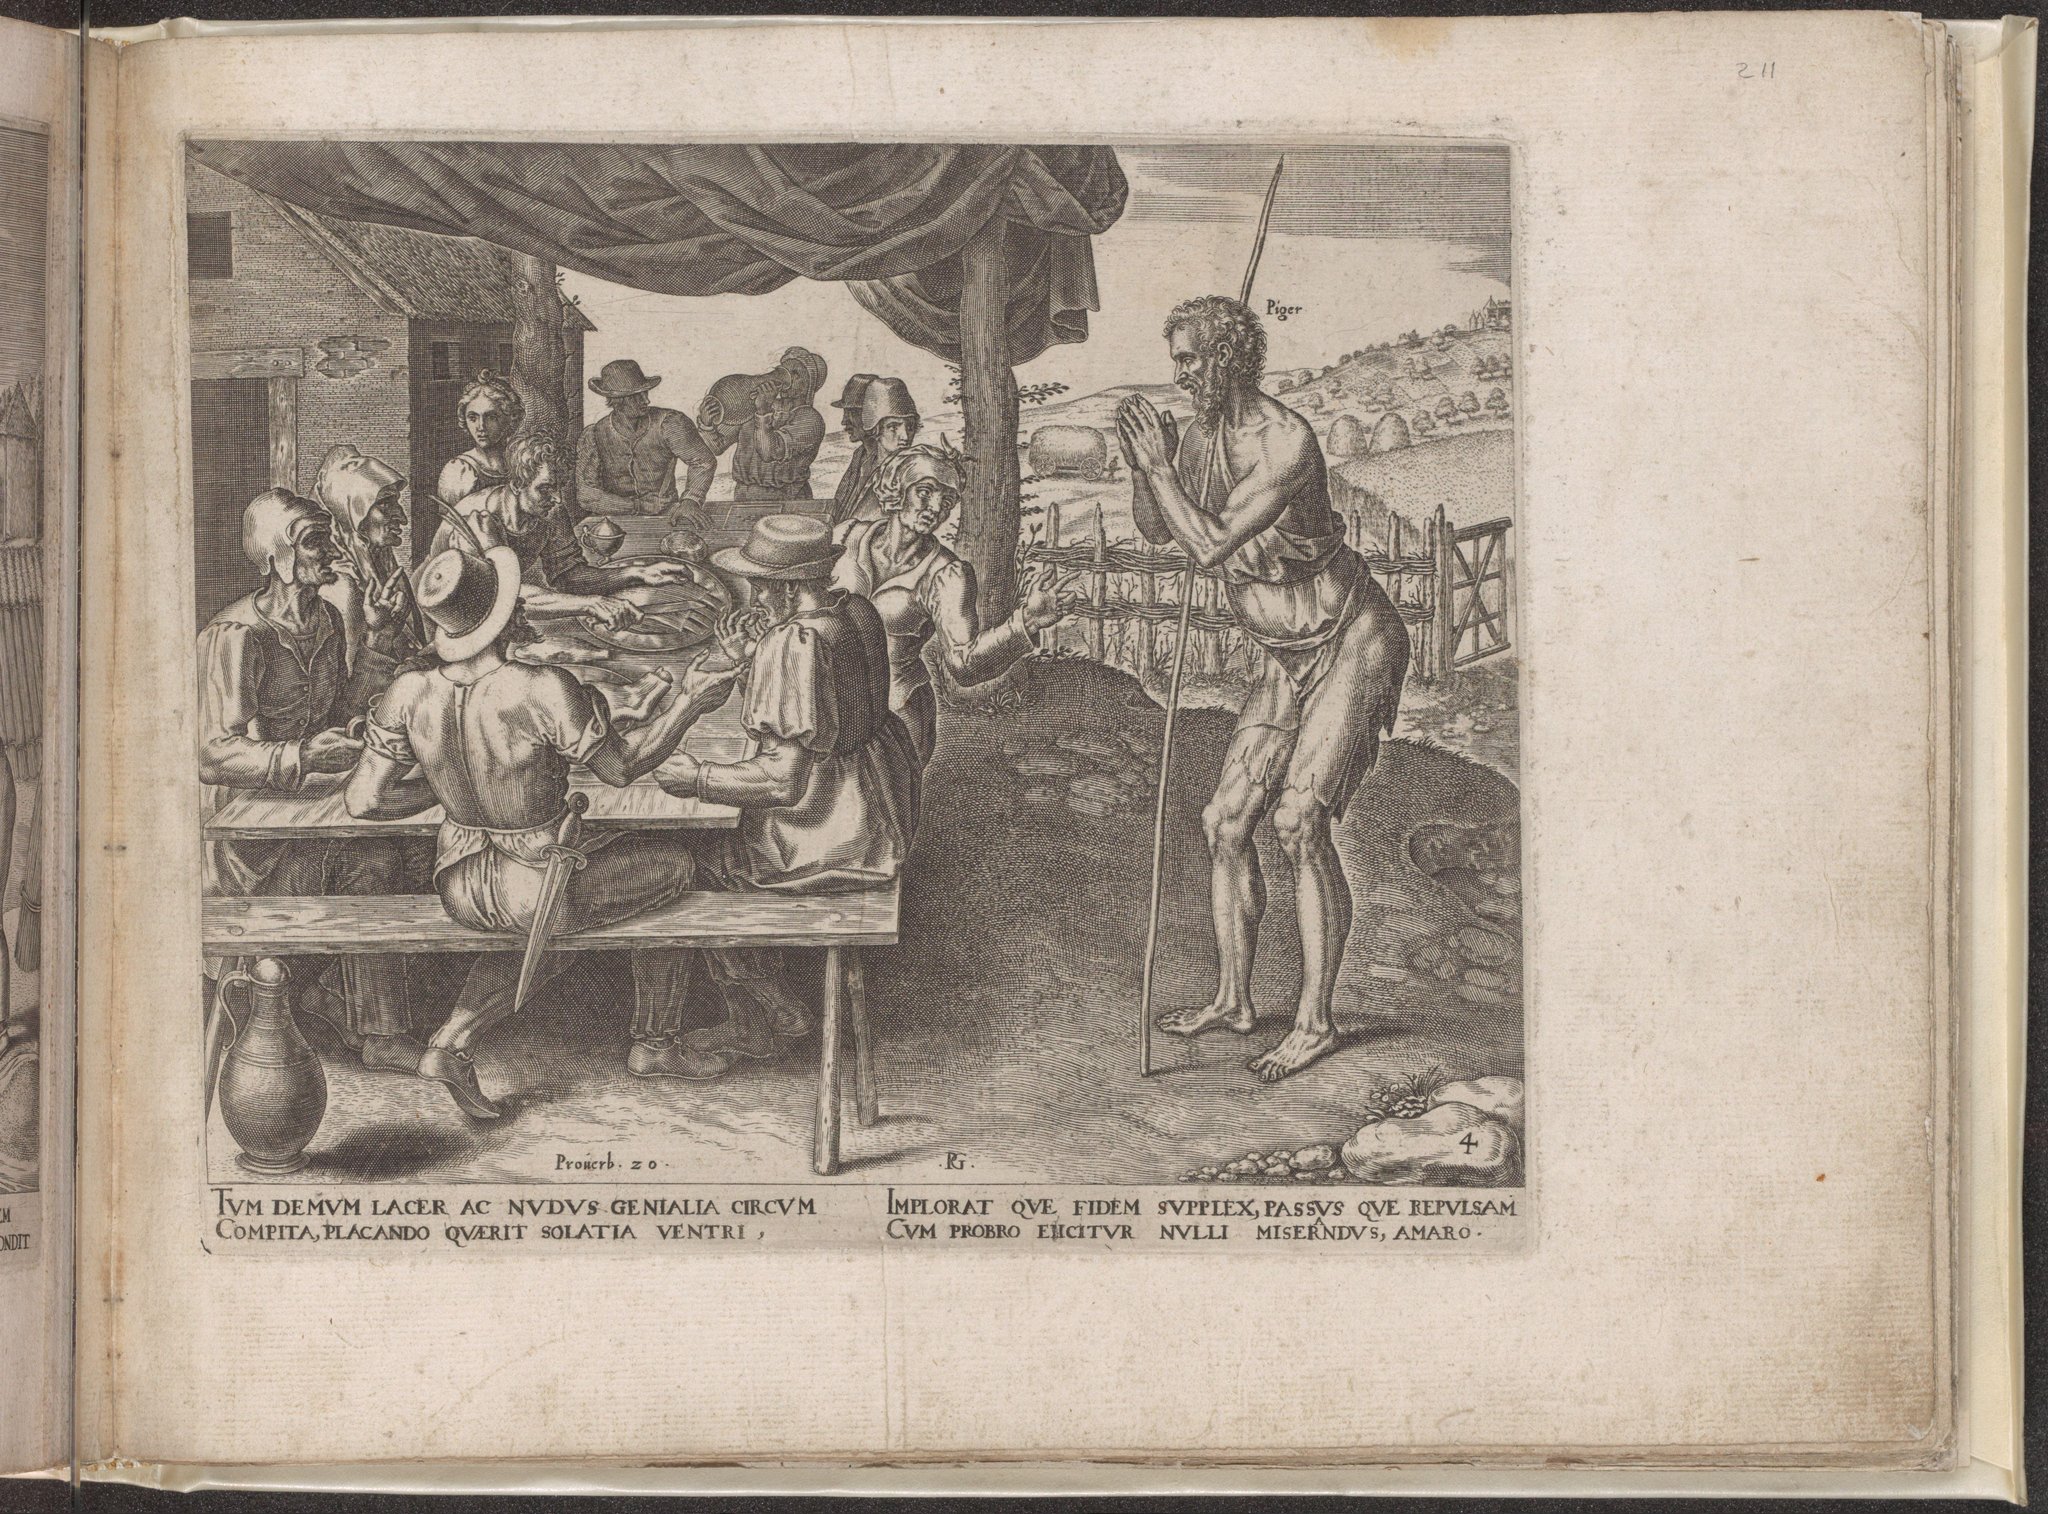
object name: print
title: De luiaard mag niet mee eten na de oogst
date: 1563-1567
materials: paper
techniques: engraving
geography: haarlem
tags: the book of proverbs, harvest festivities (+ eating and drinking ~ festive activities)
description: Mannen en vrouwen zitten naast hun huis in de buitenlucht te eten na de oogst. De luiaard, die niet heeft geholpen bij het oogsten, wordt van tafel geweerd. Hij maakt met zijn handen een biddend gebaar, maar wordt weggestuurd. Naar de Bijbeltekst in Spr. 20. Onder de voorstelling een verklarende tekst in het Latijn. Deze prent maakt deel uit van een album.